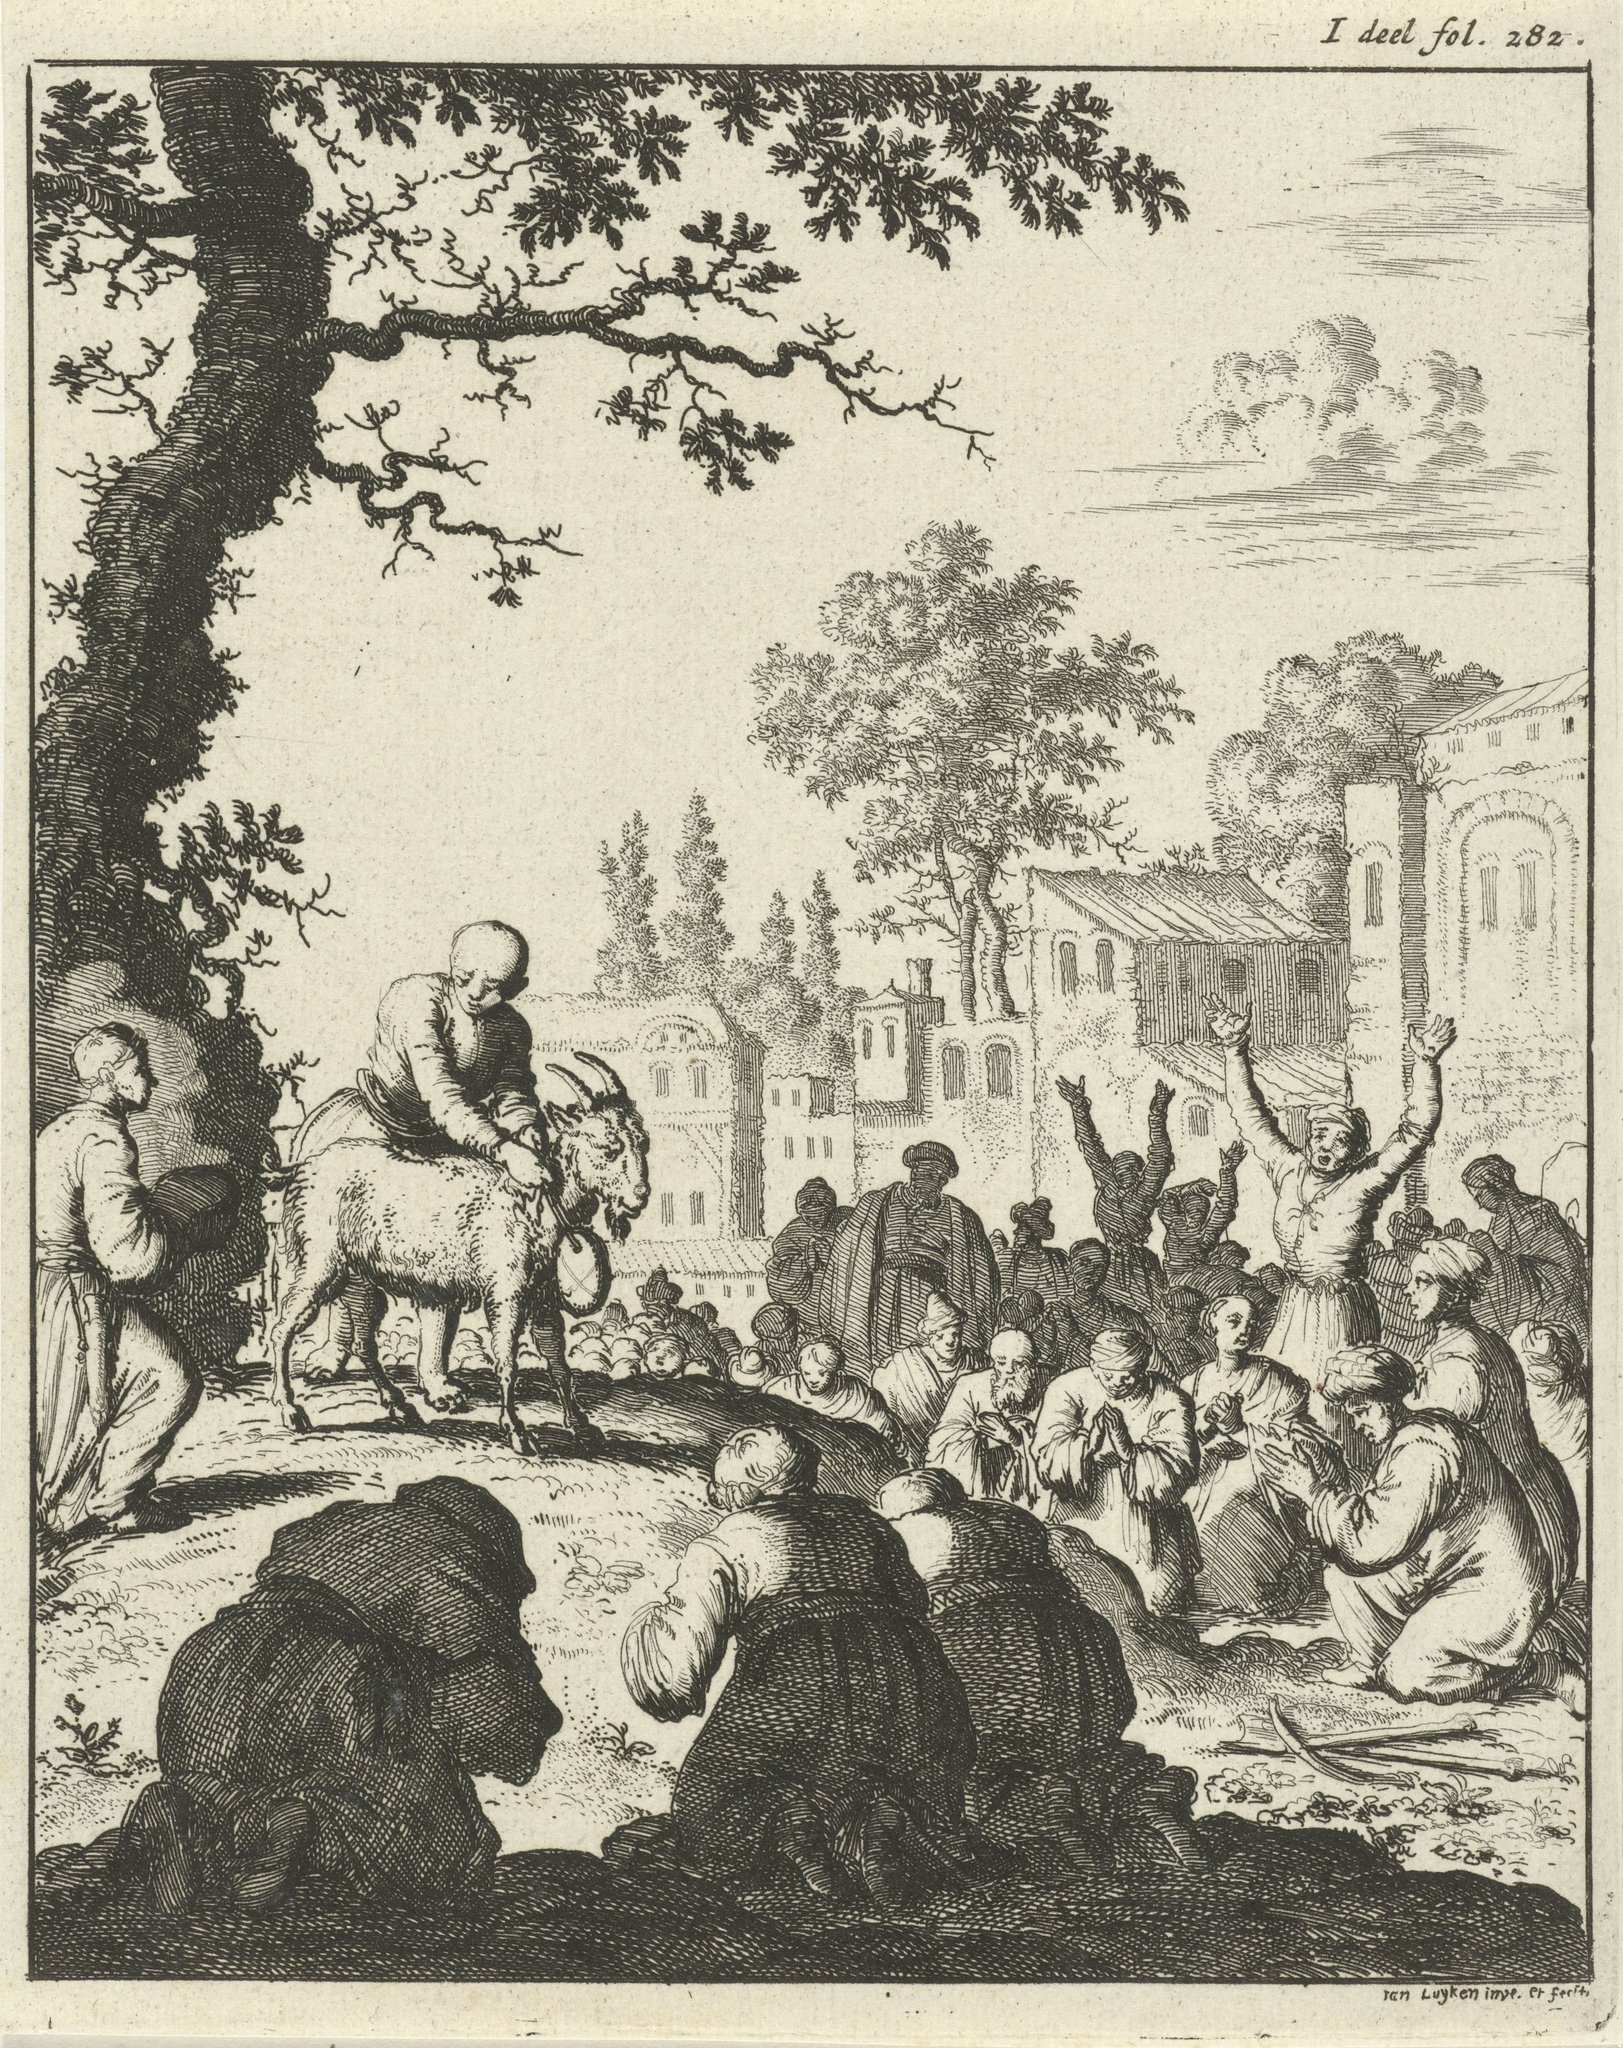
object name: book illustration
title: Viertyt van de witte Bok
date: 1682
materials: paper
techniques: etching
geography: amsterdam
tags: goat, worship and devotion ~ non-christian religions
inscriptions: collector's mark: Lugt 2228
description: Illustratie opgenomen in: Tavernier, Jean Baptiste. De Zes Reizen, 3 delen. Amsterdam: weduwe Joannes van Someren, 1682, dl. 1.